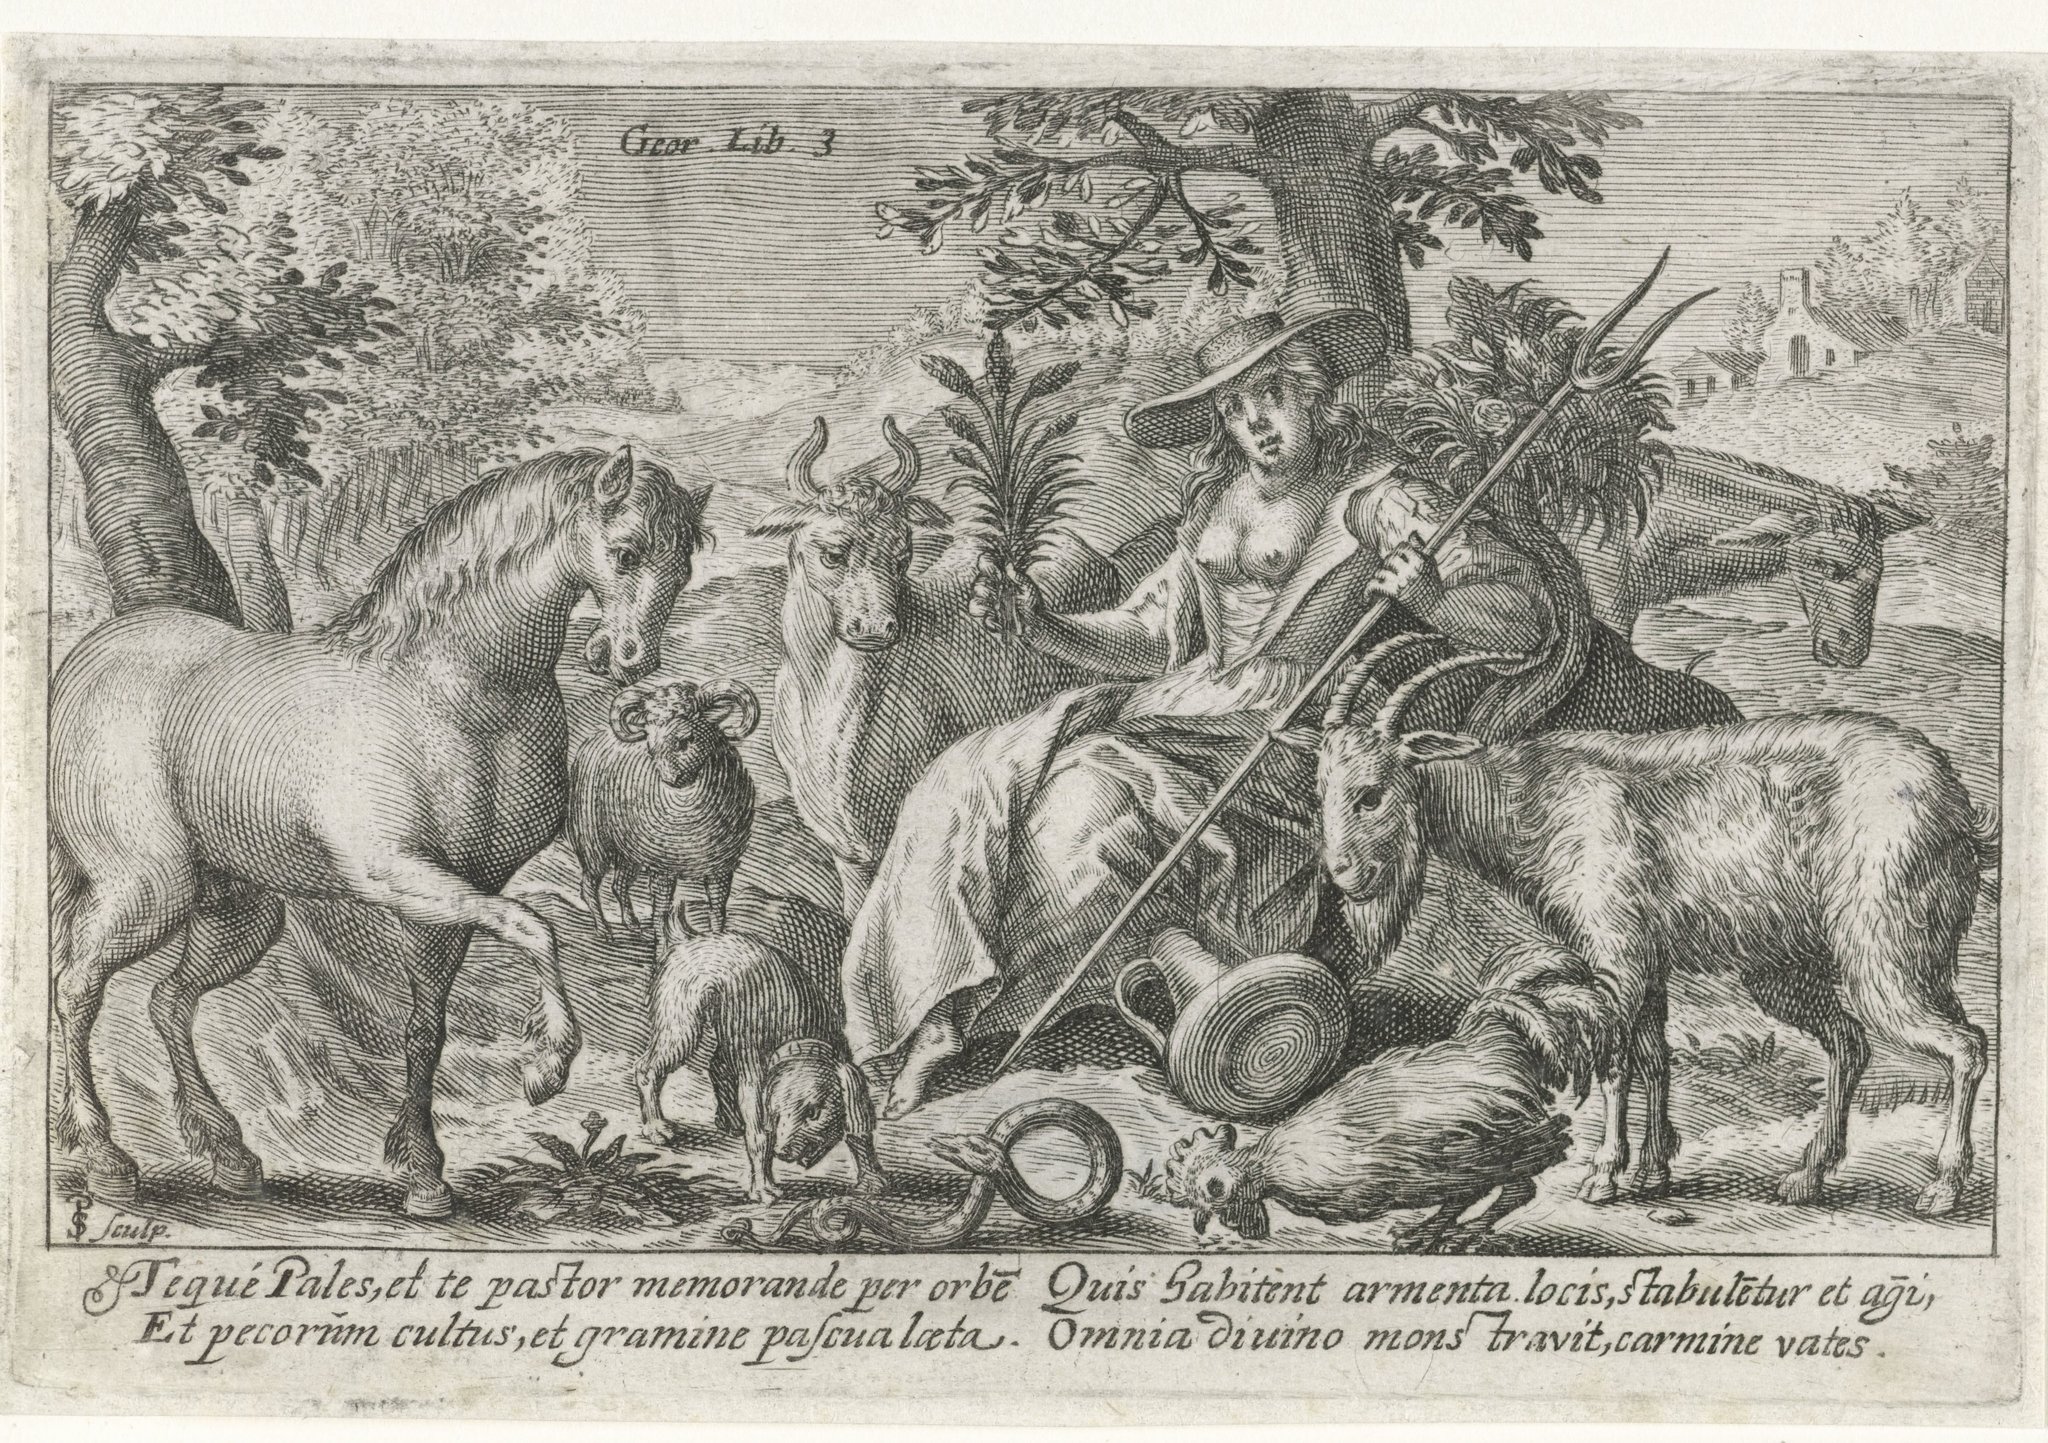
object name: print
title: Compendium Operum Virgilianorum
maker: simon van de passe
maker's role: print maker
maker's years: 1595-1647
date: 1612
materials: paper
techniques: engraving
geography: utrecht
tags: other female roman deities: pales, groups of animals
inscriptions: collector's mark: Lugt 2228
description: Landschap met de godin Pales (Romeinse godin van de herders, landbouw en veeteelt), omringd door diverse dieren. In de marge een vierregelig onderschrift, in twee kolommen, in het Latijn.